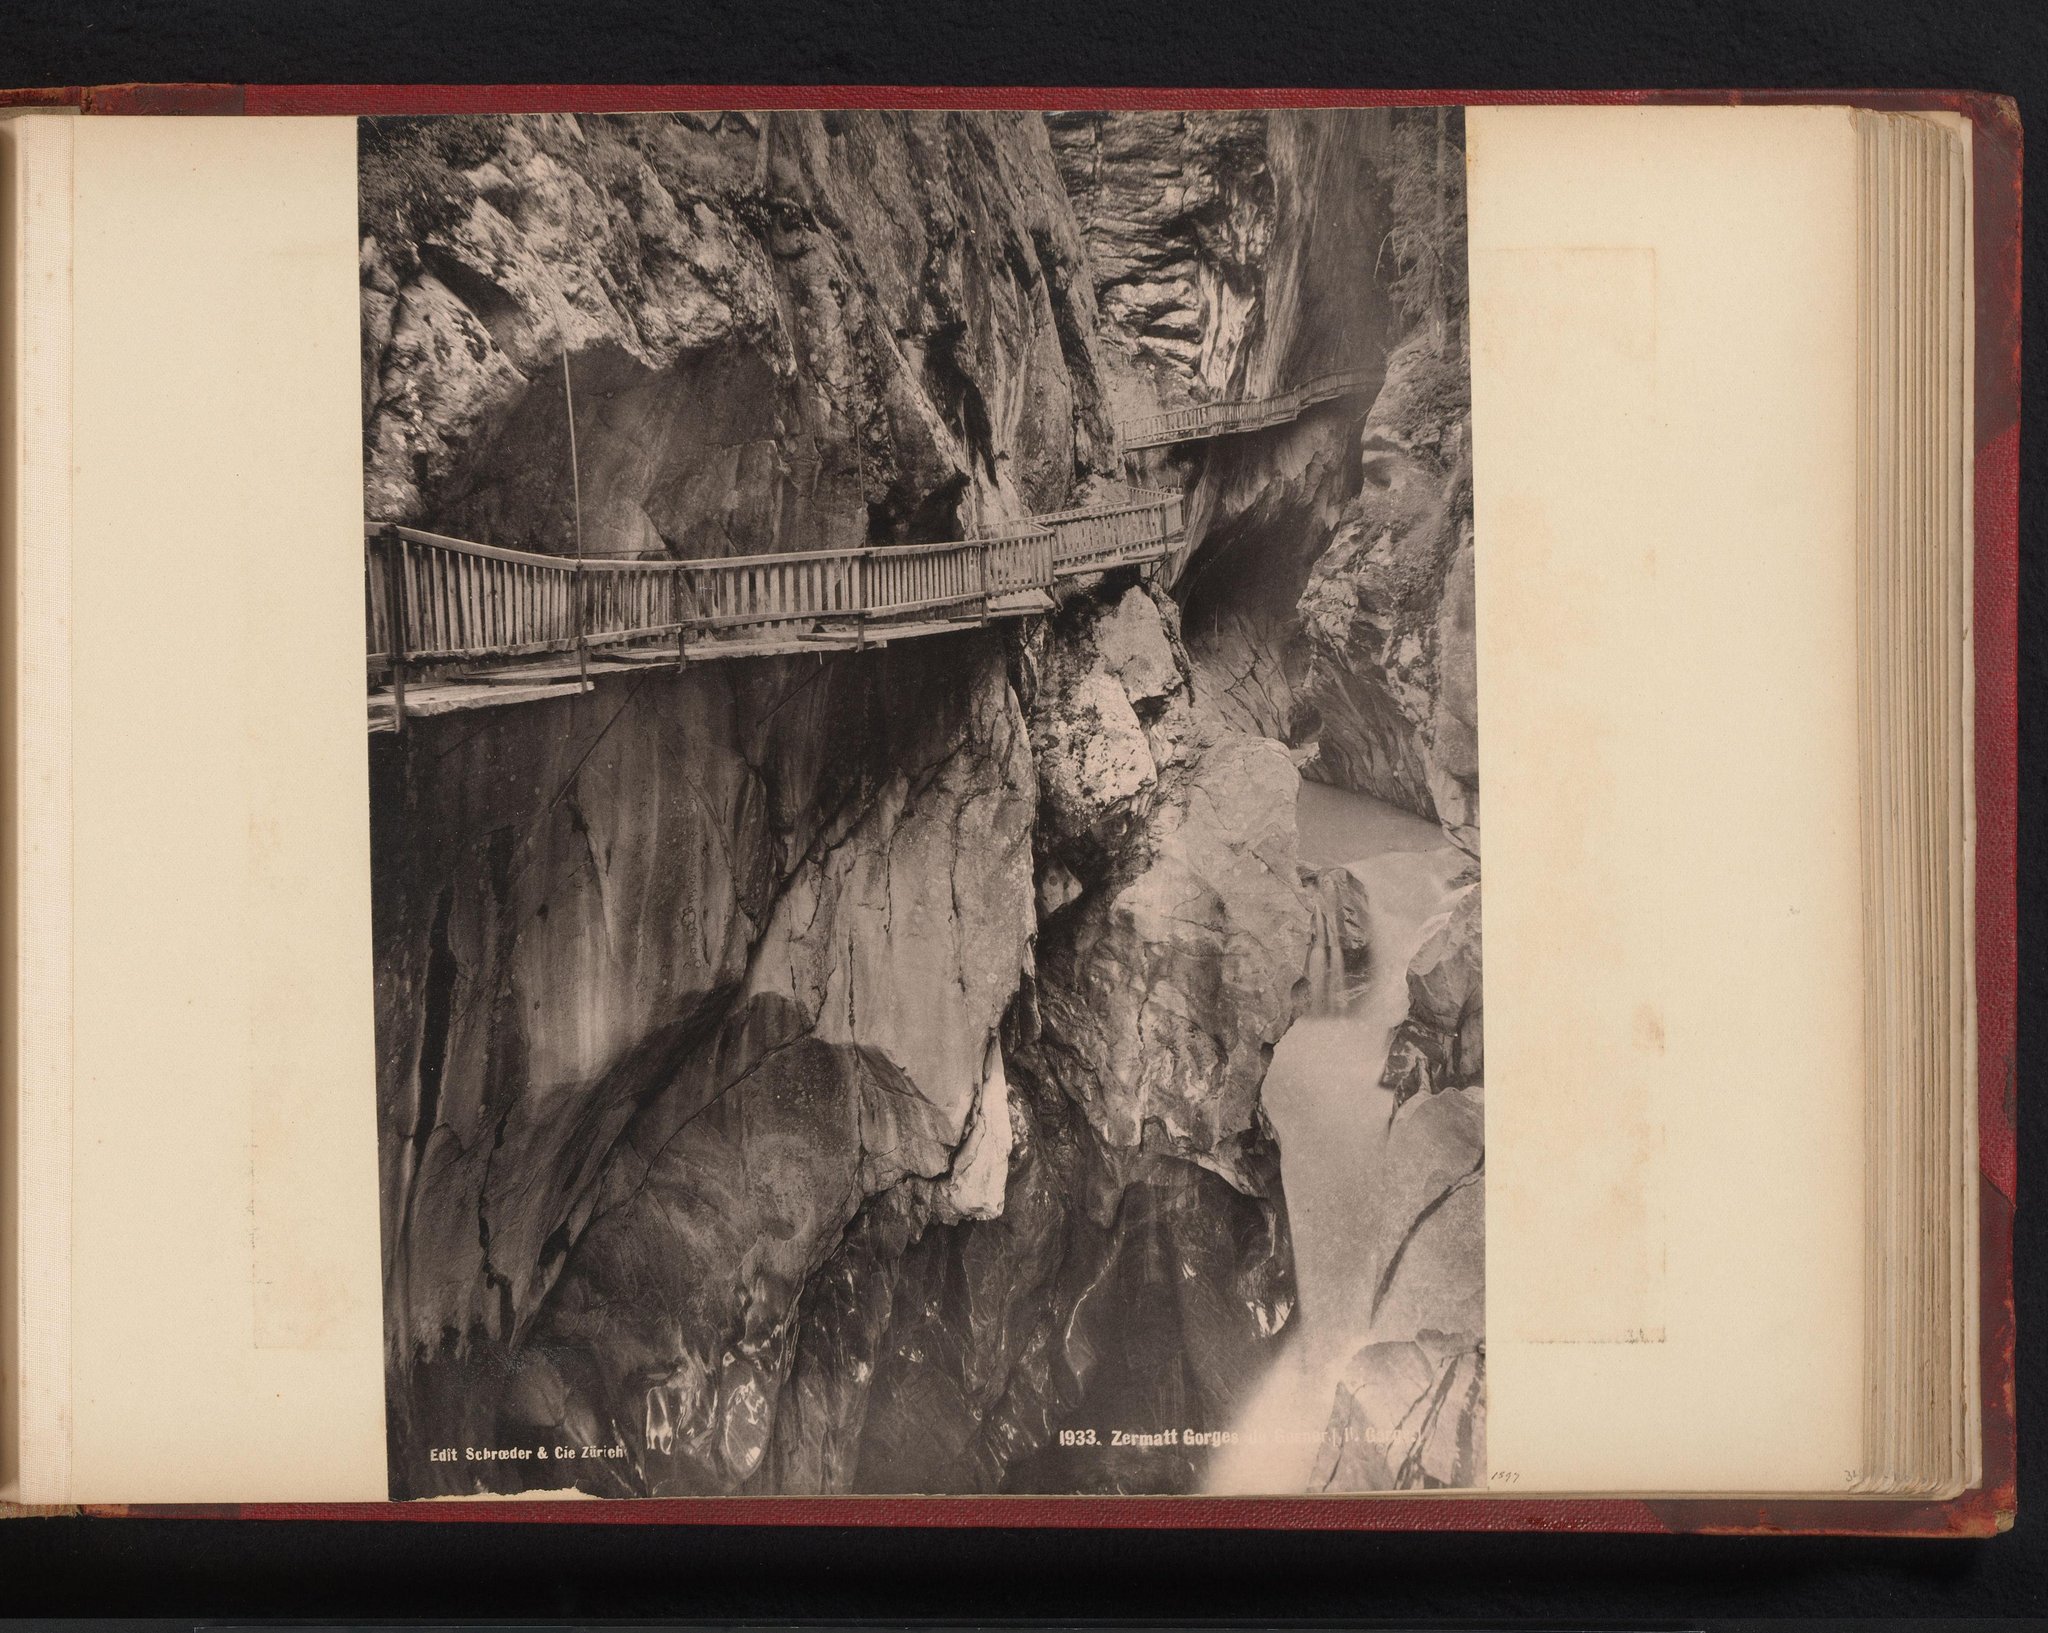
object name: album leaf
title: Gezicht op de Gornerschlucht te Zermatt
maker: Anonymous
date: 1897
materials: paper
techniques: photograph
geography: zurich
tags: ravine, chasm, abyss, canyon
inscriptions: inscription: ‘Edit Schroeder & Cie. Zürich/ 1933. Zermatt Gorges du Gorner [II. Gorge.]’, annotation: ‘1897’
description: Deze prent maakt deel uit van een album.